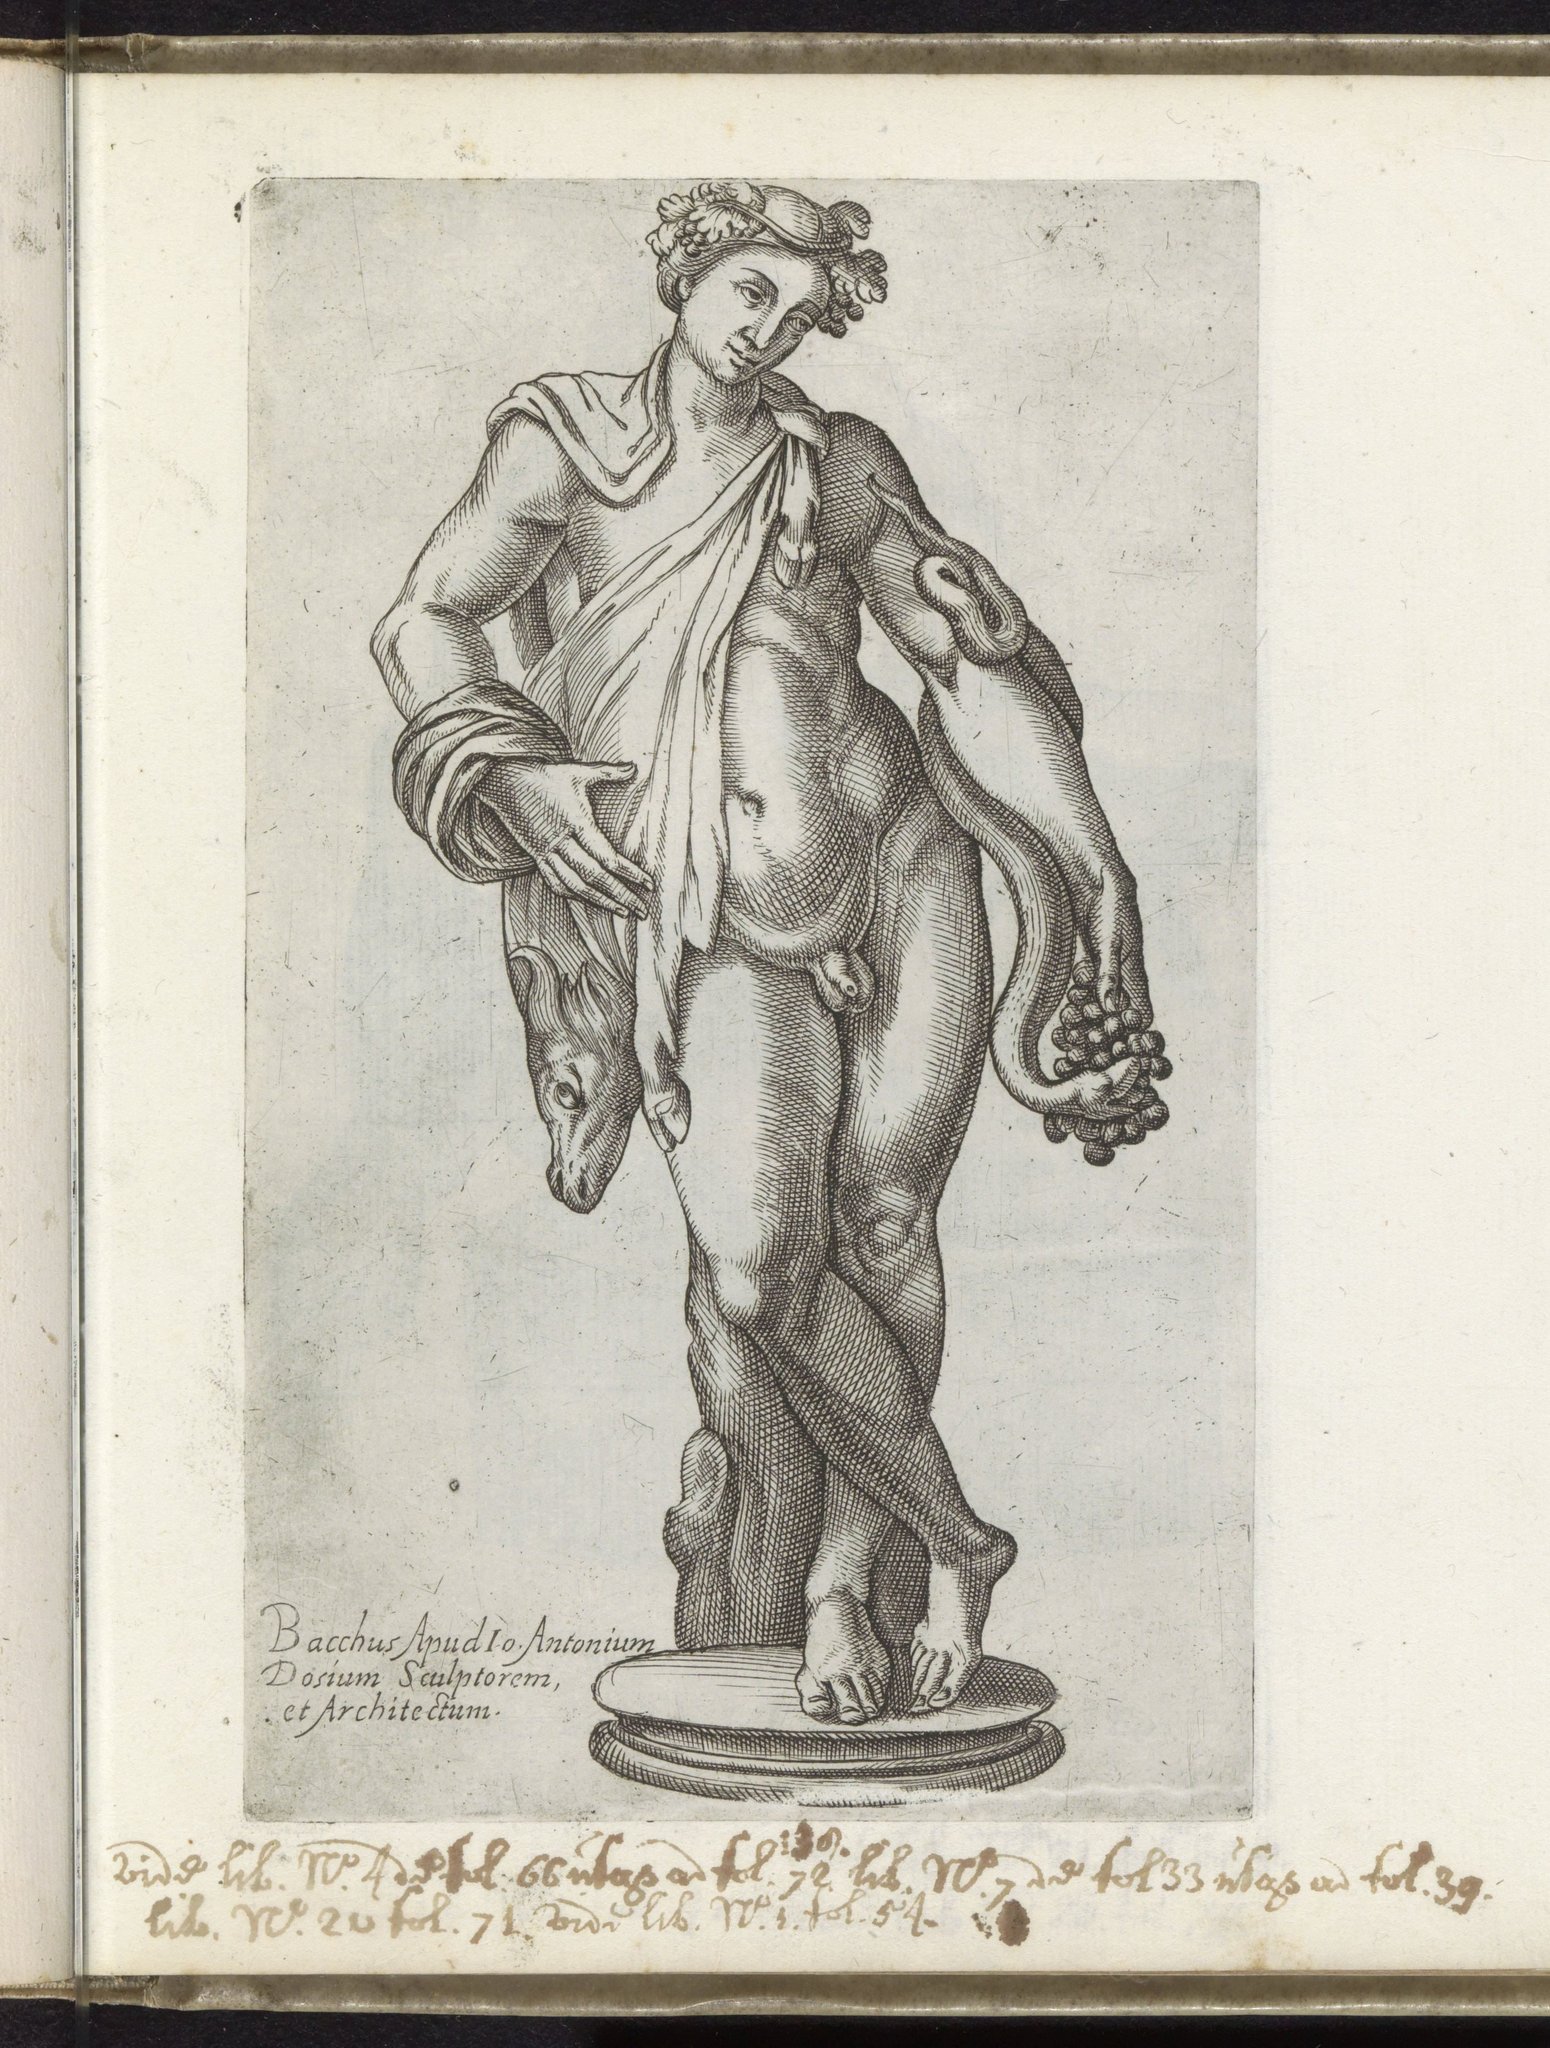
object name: album leaf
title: Sculptuur van Bacchus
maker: Anonymous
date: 1600-1699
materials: paper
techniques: engraving, etching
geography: italy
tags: (story of) bacchus (dionysus), liber, piece of sculpture, reproduction of a piece of sculpture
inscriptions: number: ‘71’, inscription: ‘Ende lib. No. 21. fol. 339. Ende lib. No. 23. fol. 79.’, inscription: ‘Ende lib. No. 4 [...] fol. 66 [...] fol. 72...’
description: Deze prent maakt deel uit van een reeks van ten minste 50 prenten van sculpturen uit de oudheid.